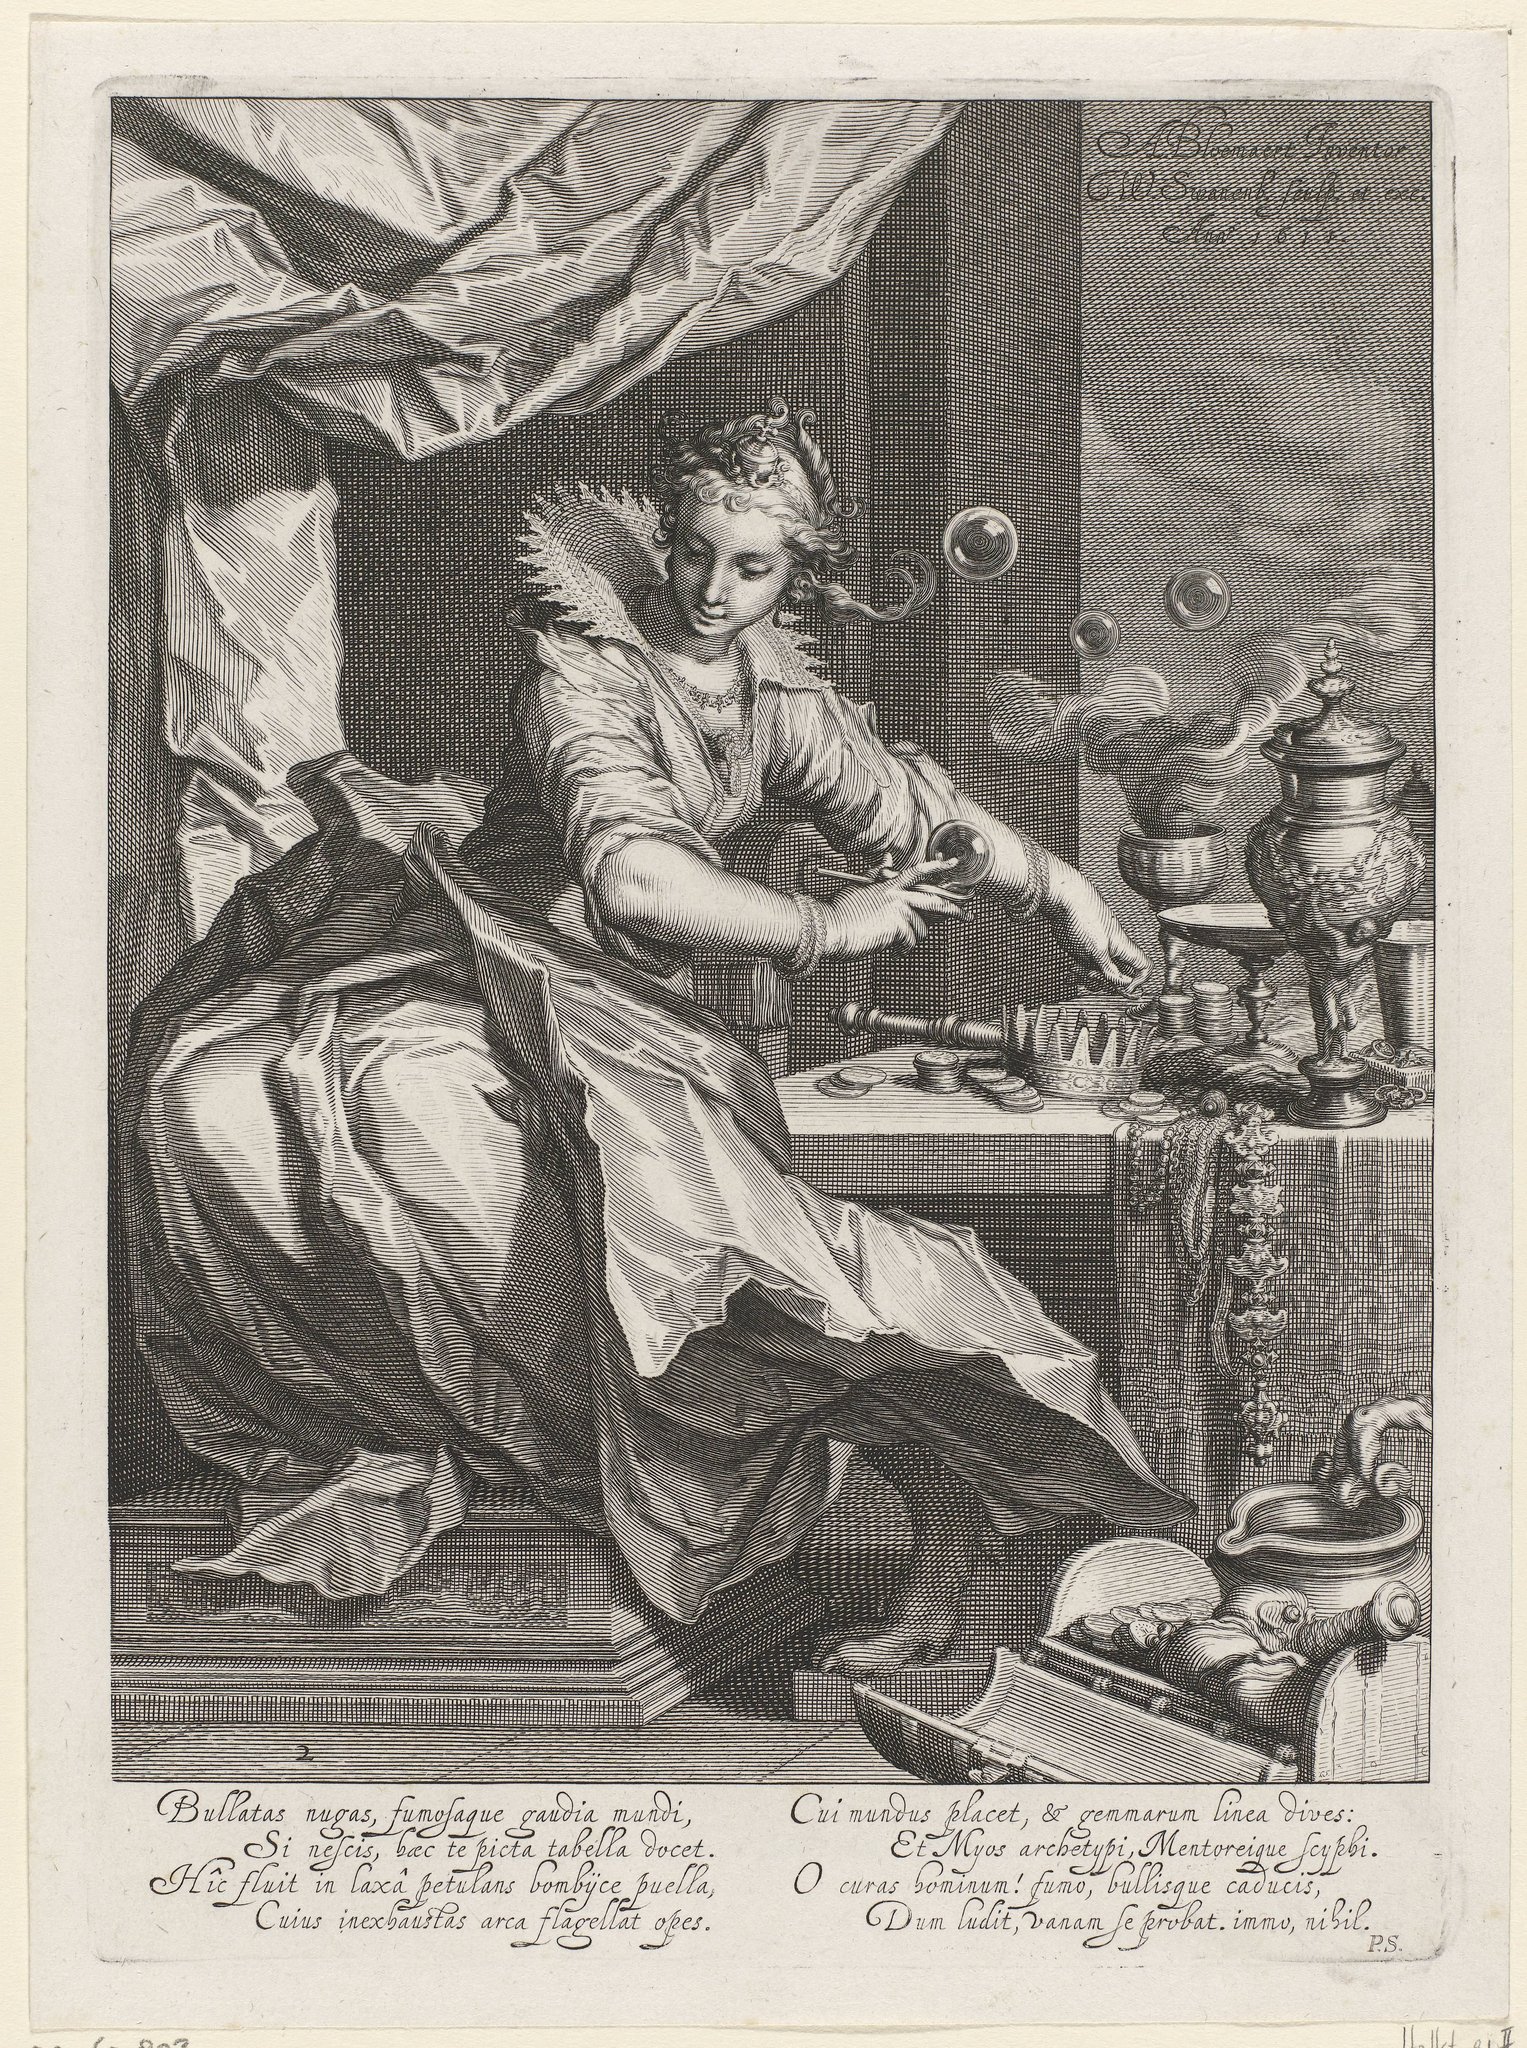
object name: print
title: Vanitas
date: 1611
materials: paper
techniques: engraving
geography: leiden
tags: scenes symbolizing 'vanitas', person(s) sitting among objects forming a 'vanitas' still life, exhibition of wealth, money-chest, treasure-chest, money-box, smoking pot as symbol of 'vanitas', (children or putti) blowing bubbles, 'homo bulla' ~ scene symbolizing 'vanitas'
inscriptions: collector's mark: Lugt 240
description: Een vrouw in een zijden jurk draagt haarversiering in de vorm van een rijksappel. Ze personifieert vroomheid. In haar rechterhand houdt ze een bellenblaas. Ze zit aan een tafel met kostbaarheden, onder andere munten, een kroon, een scepter en halssieraden. Ook staat er een rokende kelk.Voor de tafel staat een gevulde schatkist. Onder de voorstelling bevindt zich een achtregelige, Latijnse tekst met een afkeurende beschrijving van de voorstelling.